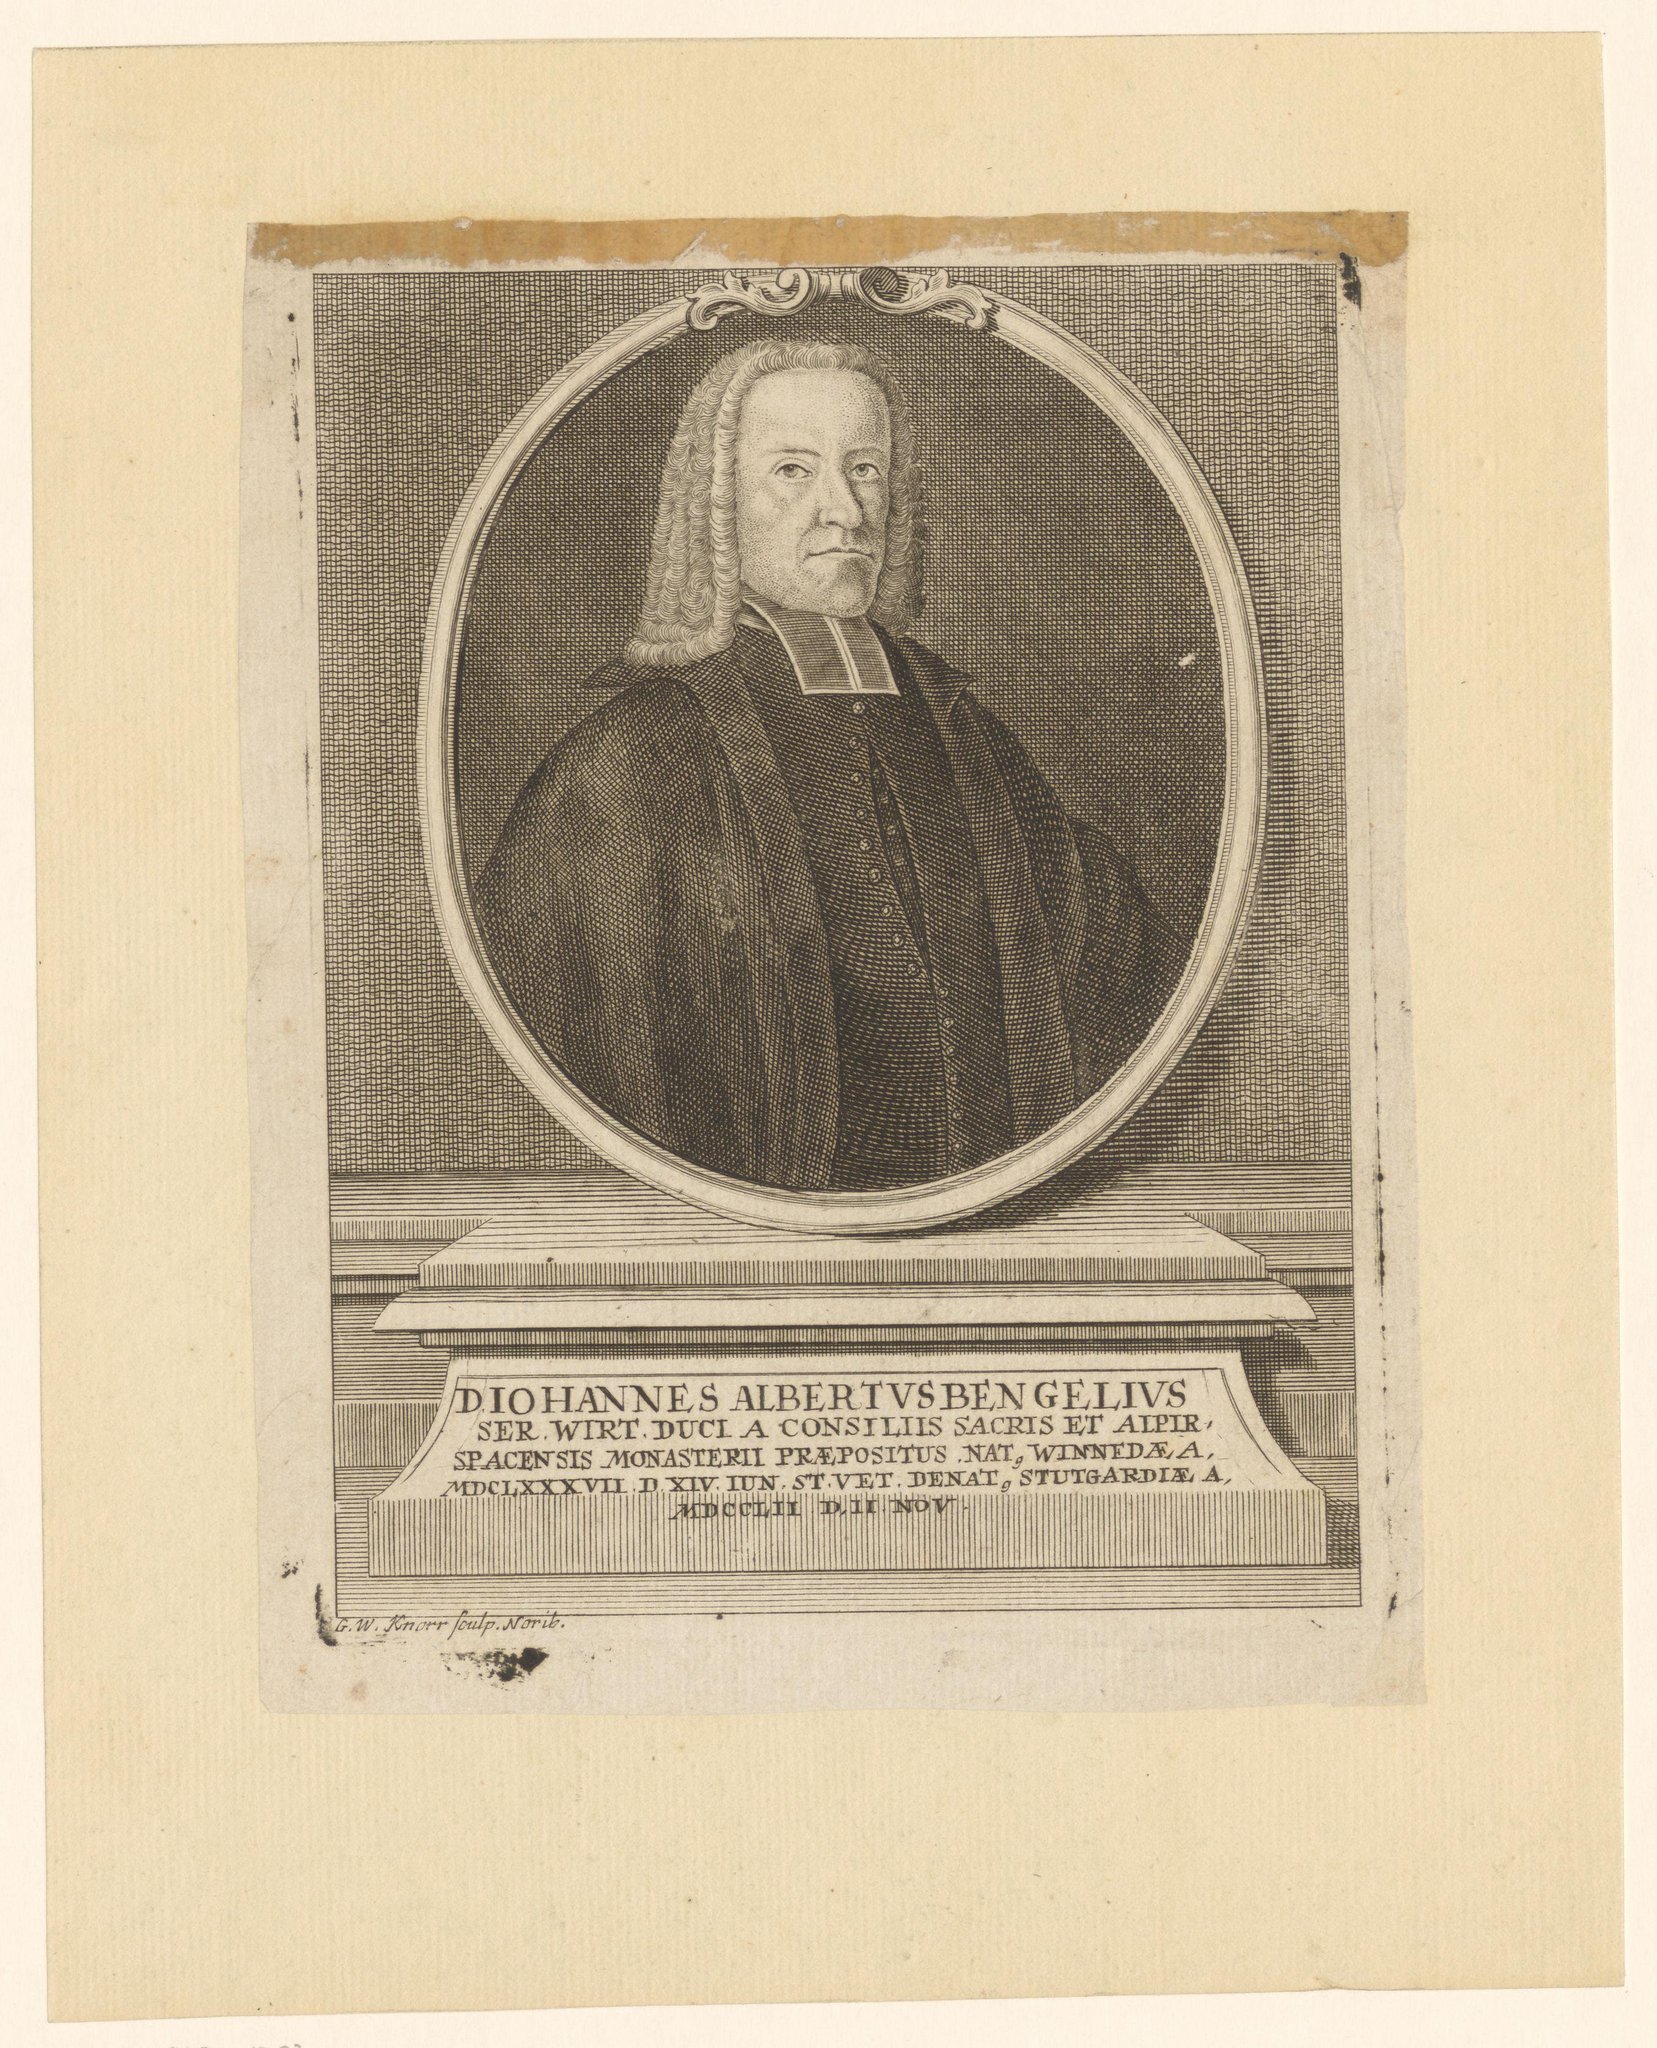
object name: print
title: Portret van Johann Albrecht Bengel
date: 1752-1761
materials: paper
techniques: engraving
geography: nuremberg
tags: theologian, historical persons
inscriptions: collector's mark: Lugt 2228